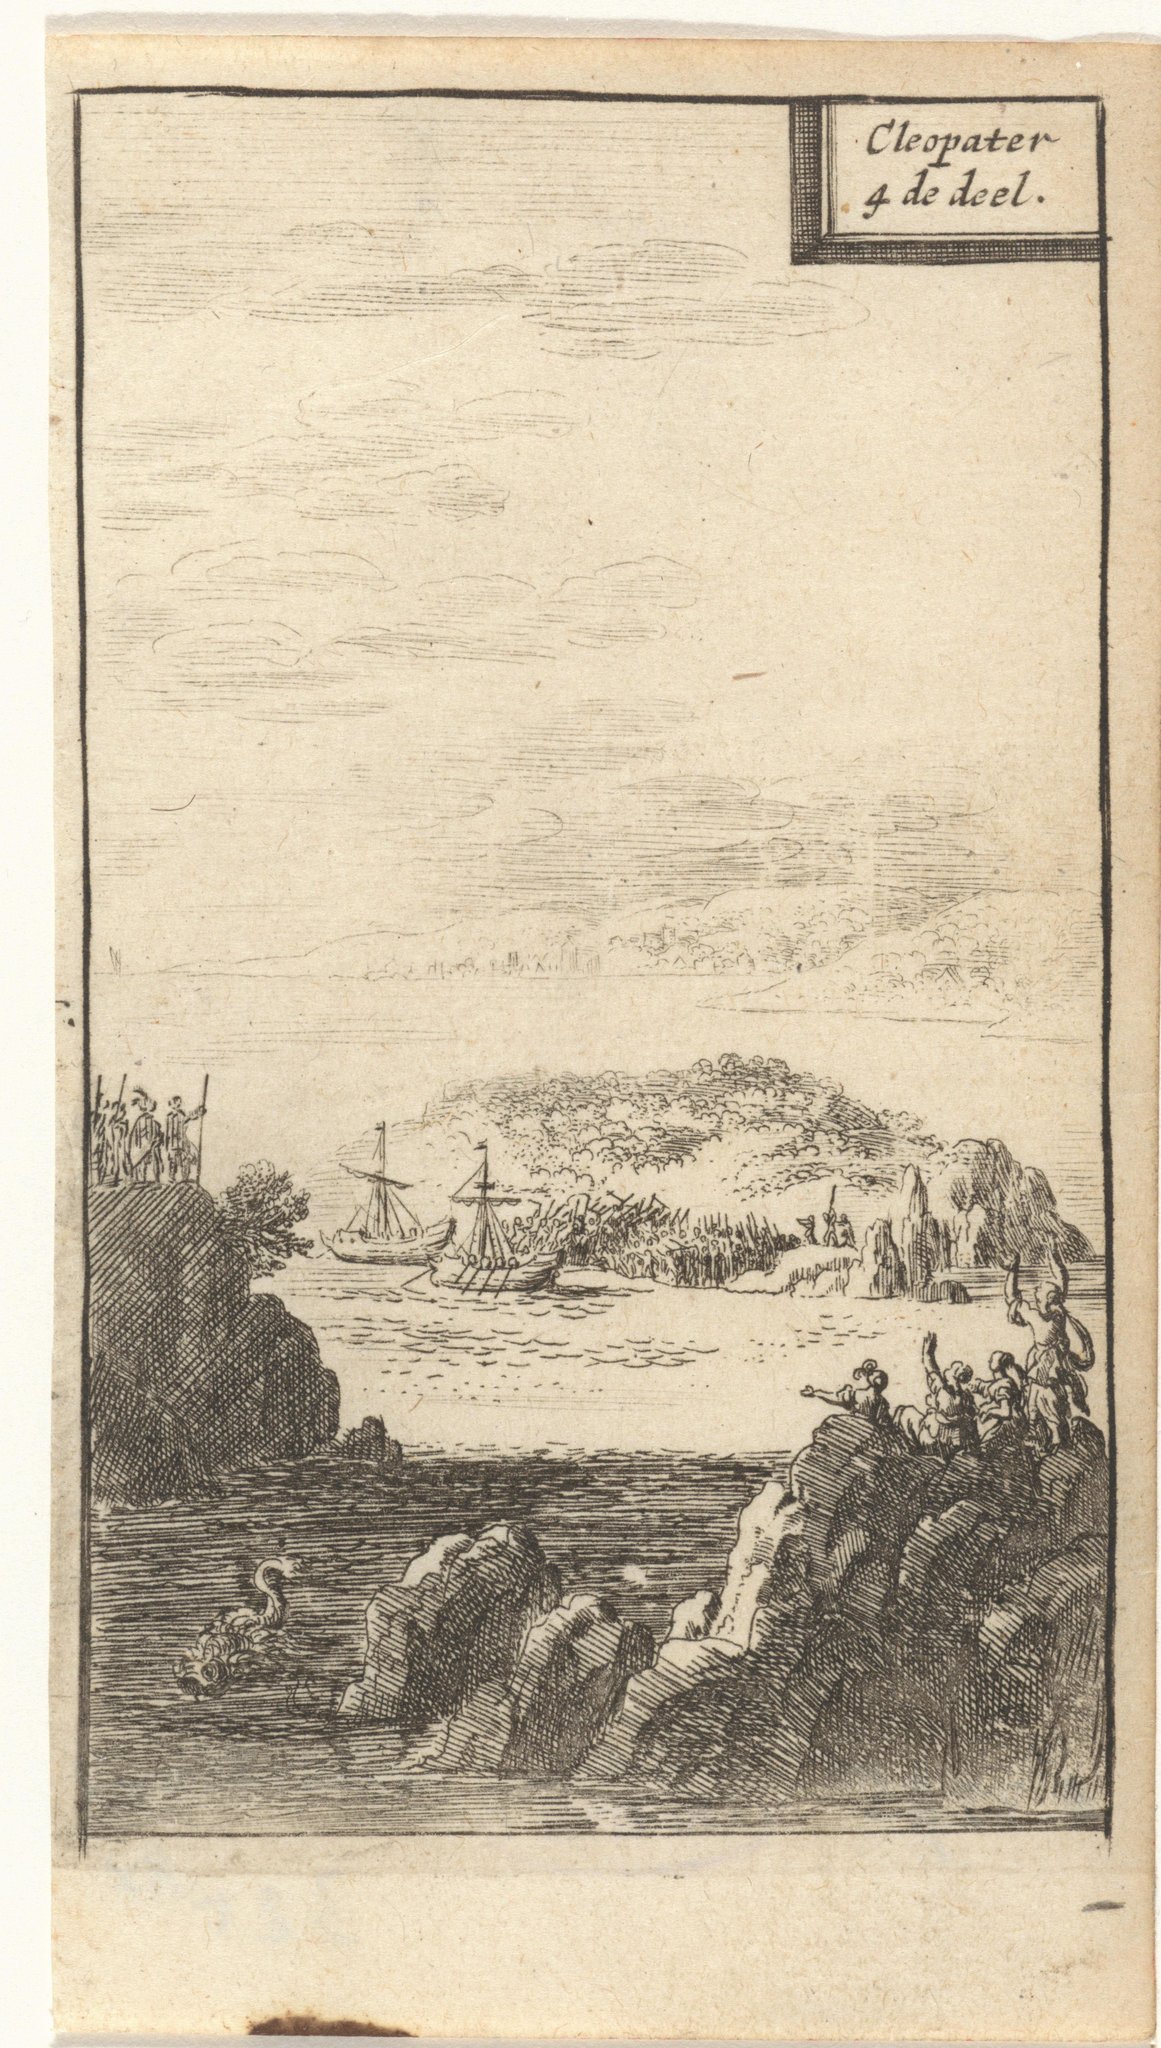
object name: titelblad, titelpagina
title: Titelpagina voor: Calprenède, La. Cleopatre 4de deel (...), 1667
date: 1667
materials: paper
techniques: etching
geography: amsterdam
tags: gulf, bay, adult woman, title-page, fishes, the soldier; the soldier's life, rock-formations, trireme, galley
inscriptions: collector's mark: Lugt 2228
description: In de verte varen twee galeien met soldaten in een baai. Vanaf de rotsachtige kust kijken soldaten toe. Rechts vooraan zwaaien enkele vrouwen vanaf de rotsen. Links vooraan zwemt een grote vis.